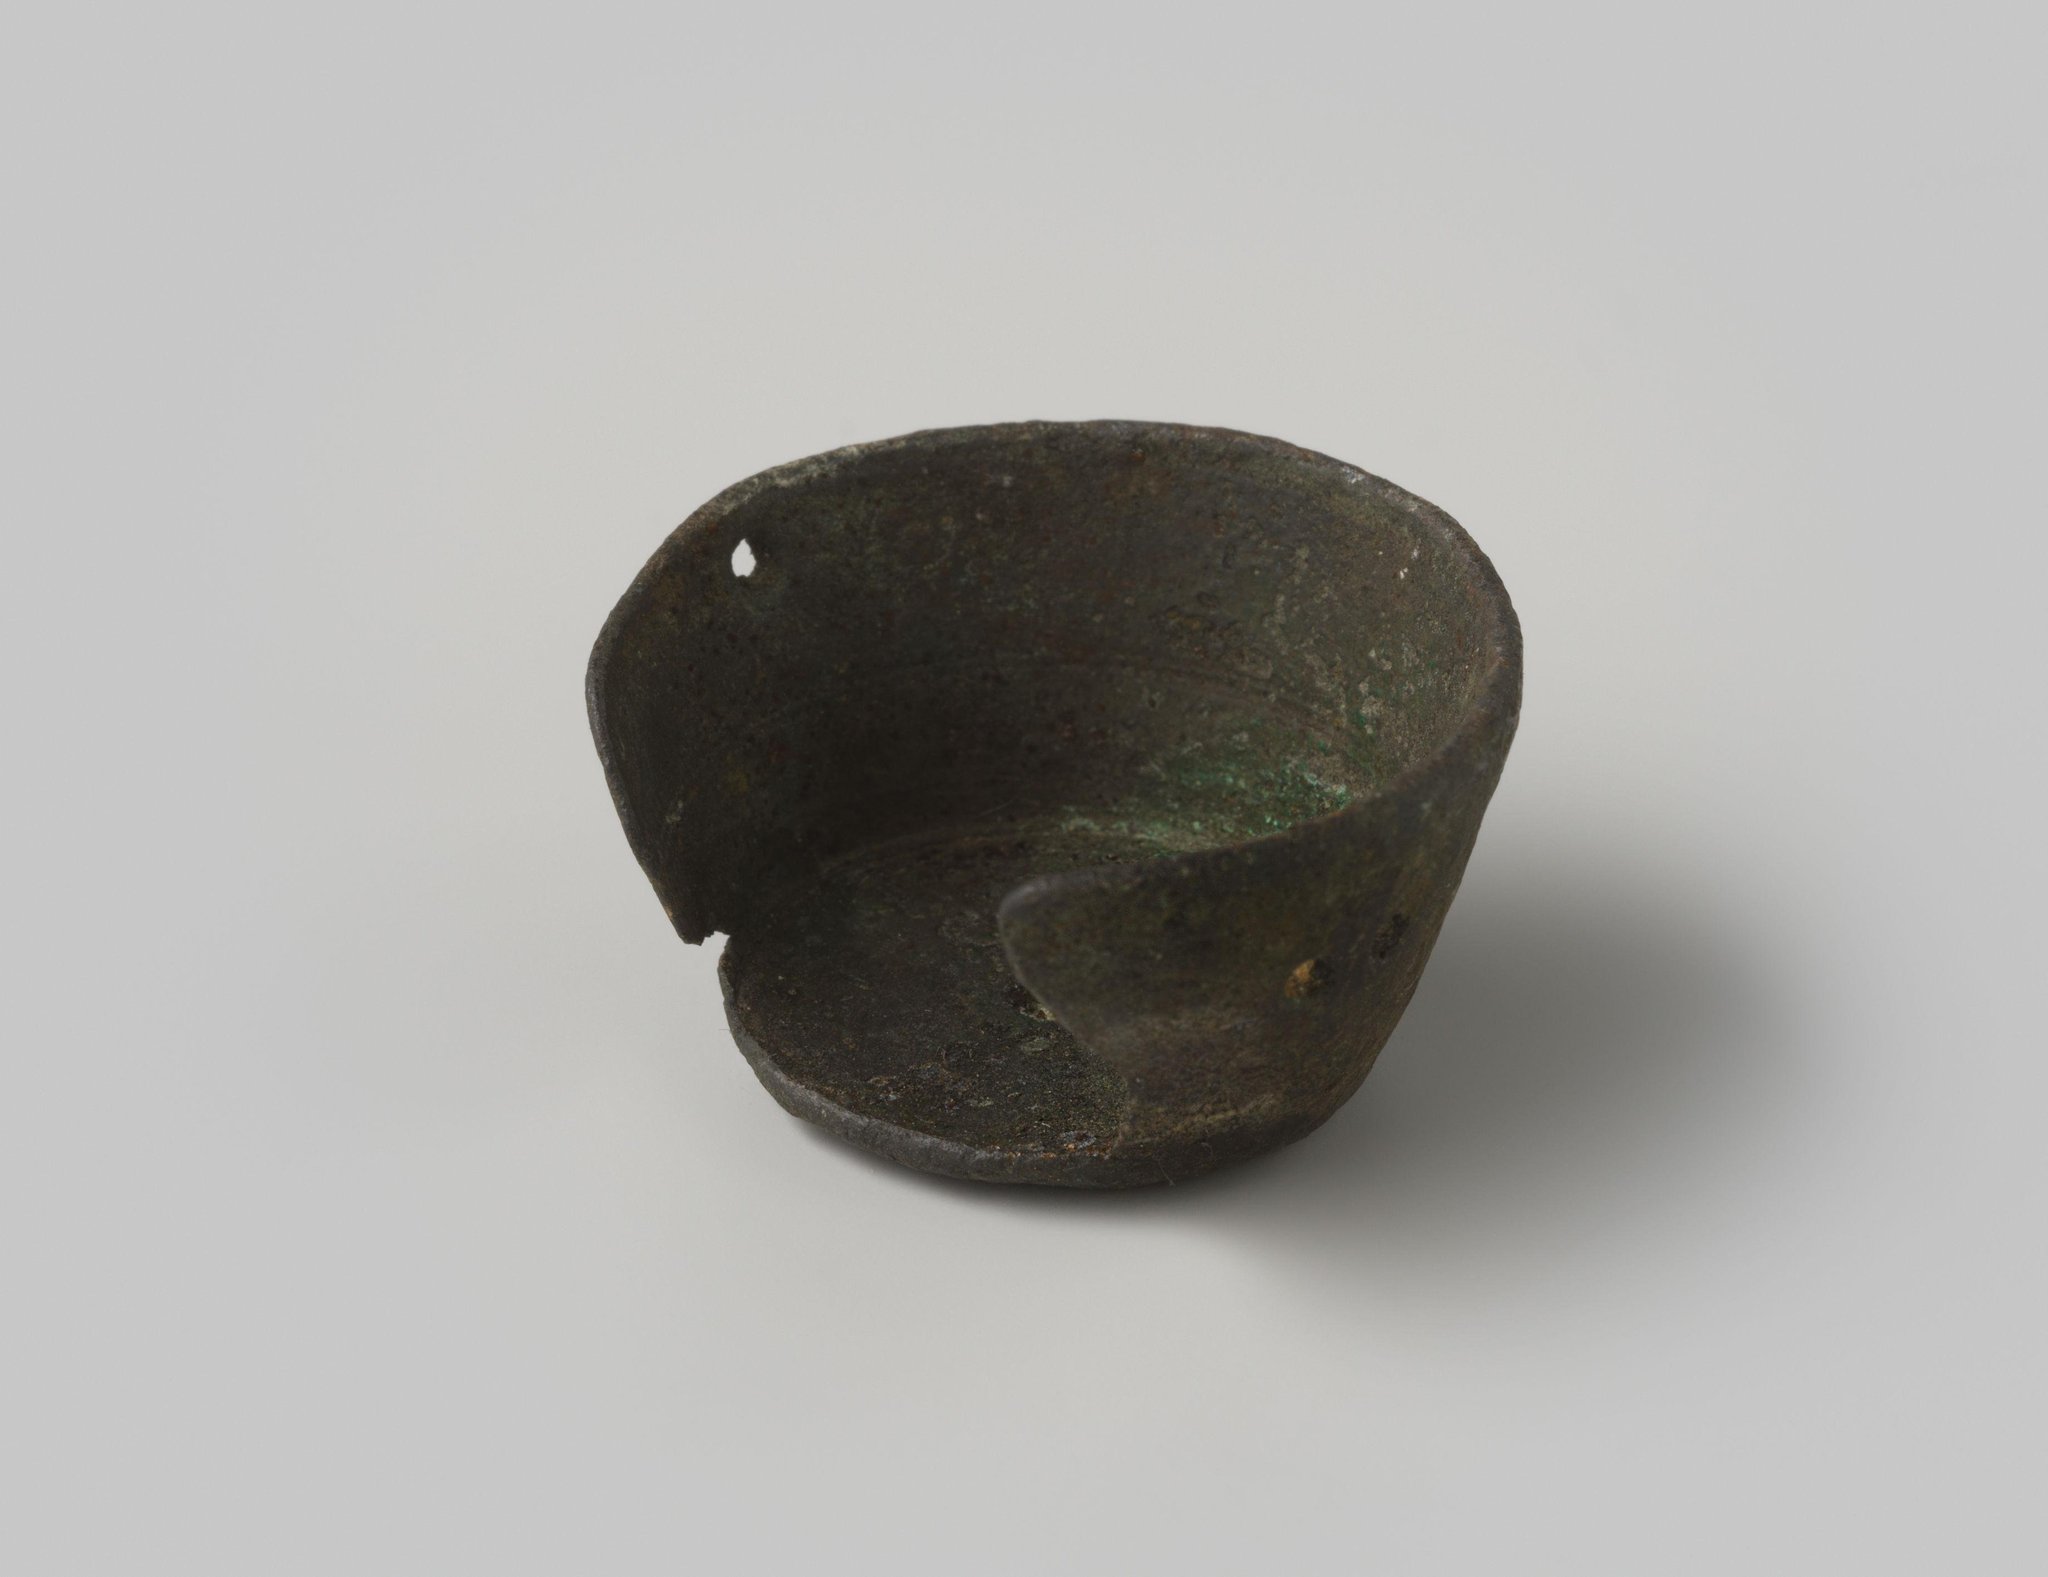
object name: sluitgewicht, pijlgewicht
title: Gewicht van sluitgewicht uit het wrak van de Oost-Indiëvaarder Hollandia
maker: Anonymous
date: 1700-1743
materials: copper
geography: netherlands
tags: verenigde oostindische compagnie, hollandia (schip), annet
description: Weight, cupweight, cup; fragment of outer cup, id. NG 1980-27H2775, corroded, id. marks.